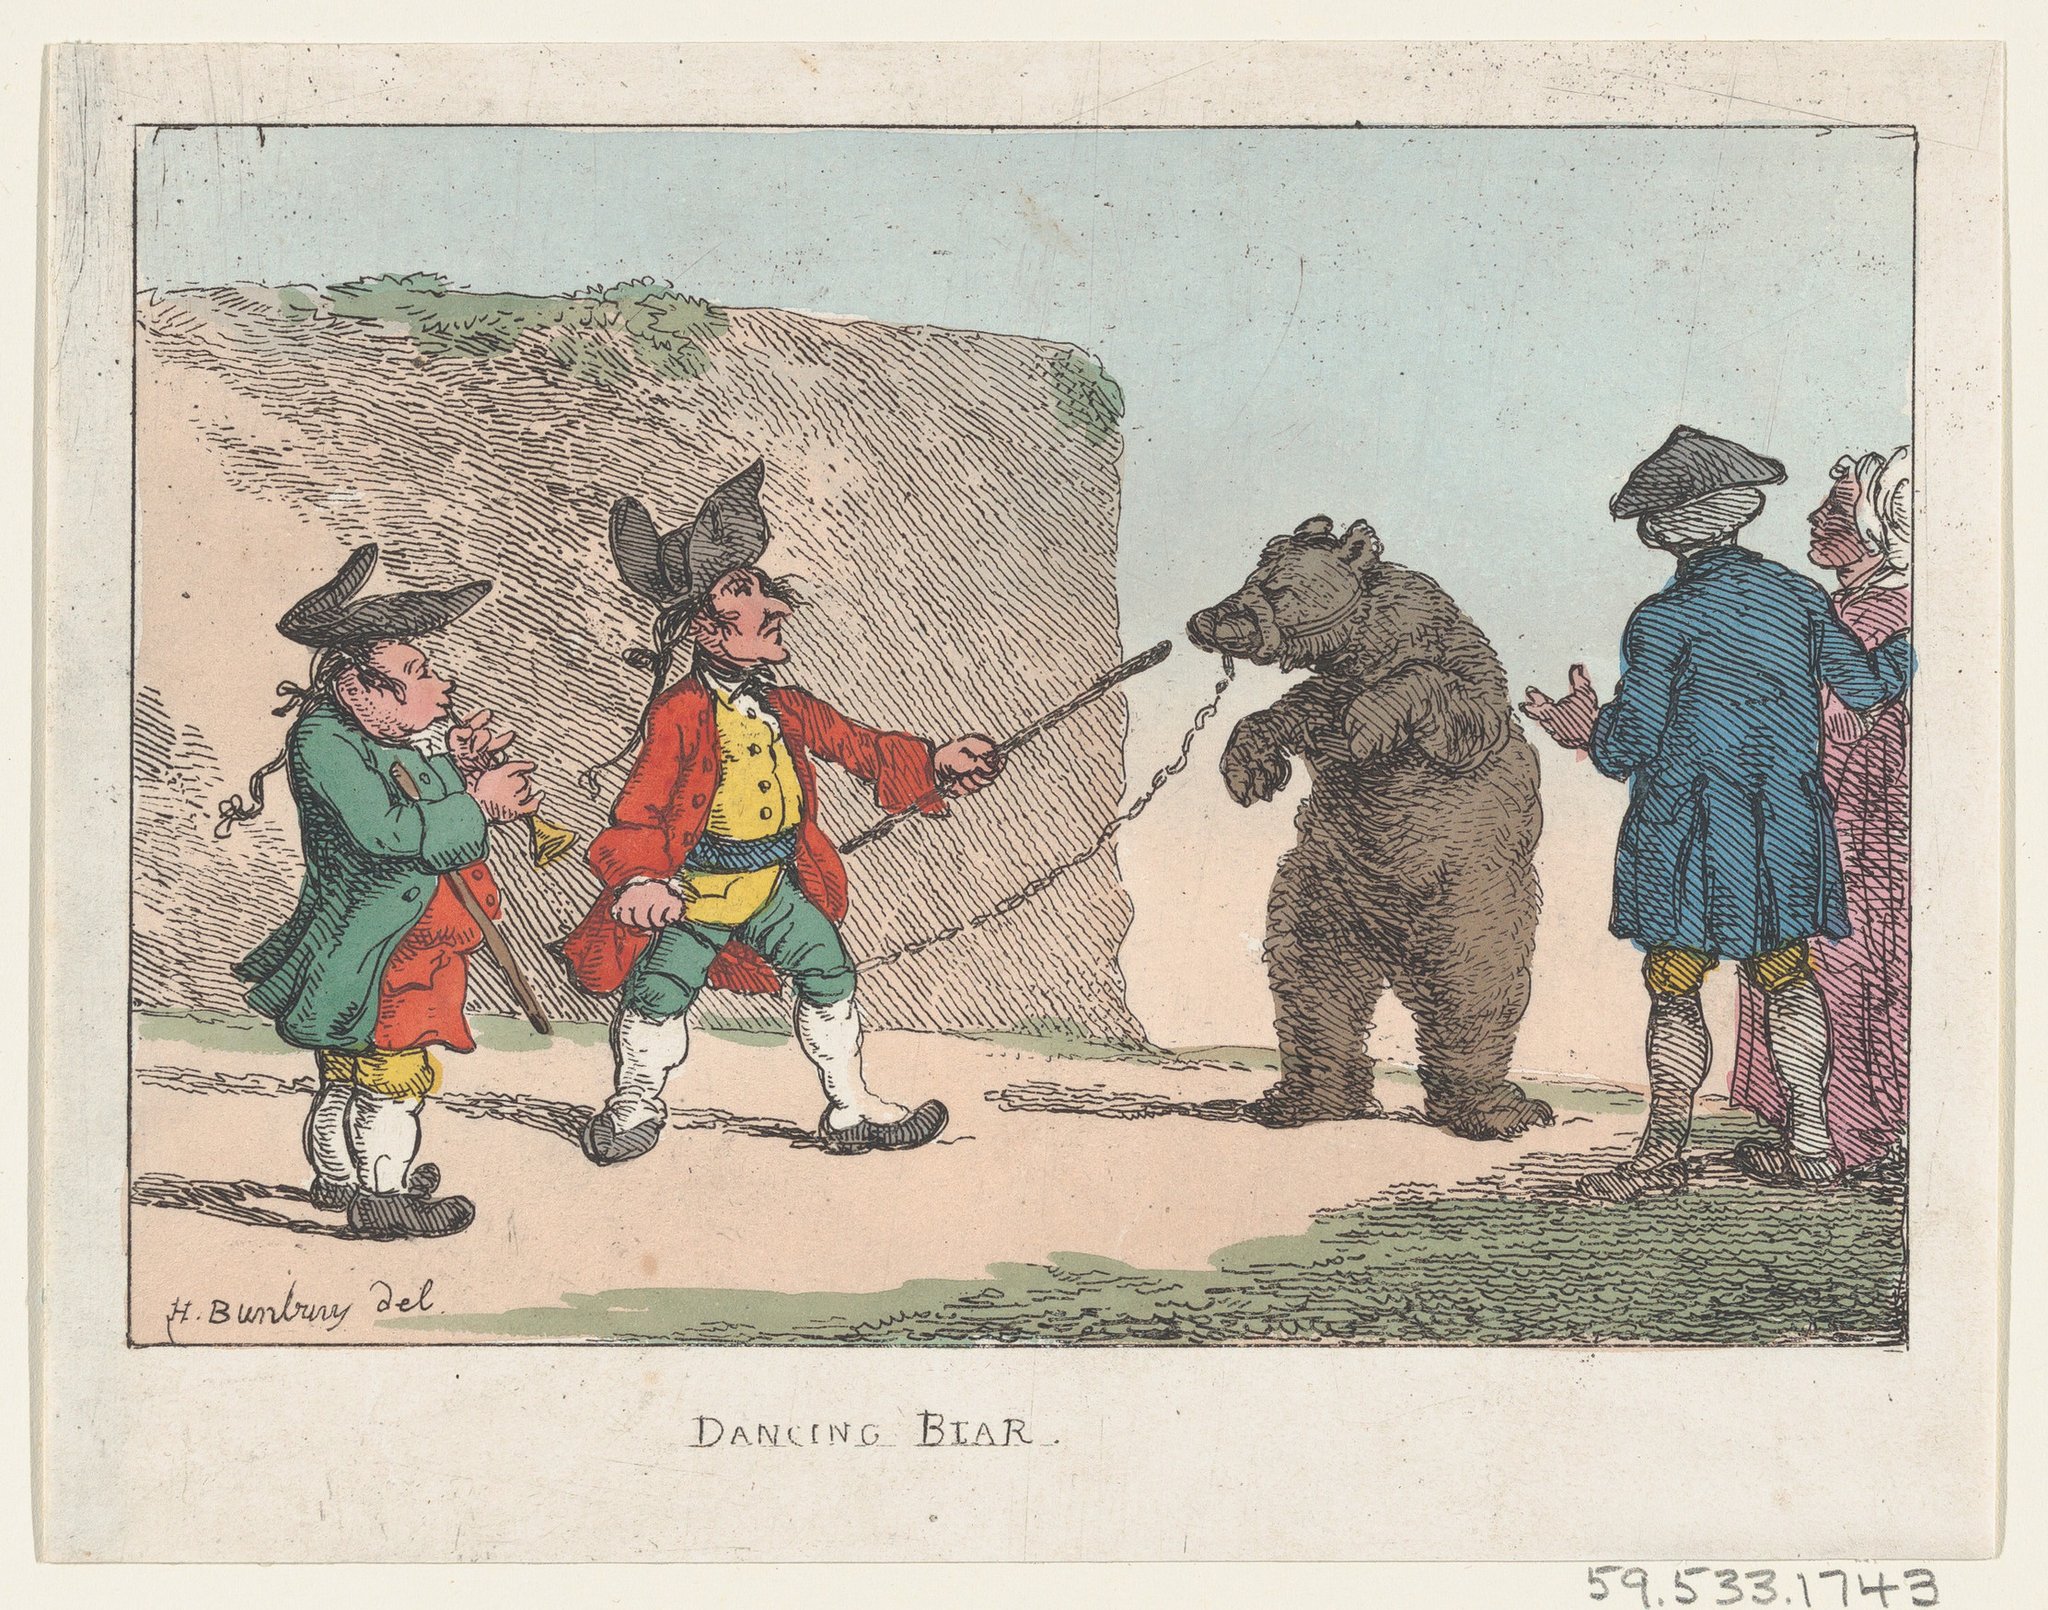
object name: print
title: A Dancing Bear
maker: thomas rowlandson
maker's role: artist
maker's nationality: british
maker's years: 1757-1827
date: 1800-1827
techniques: etching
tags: bears,men